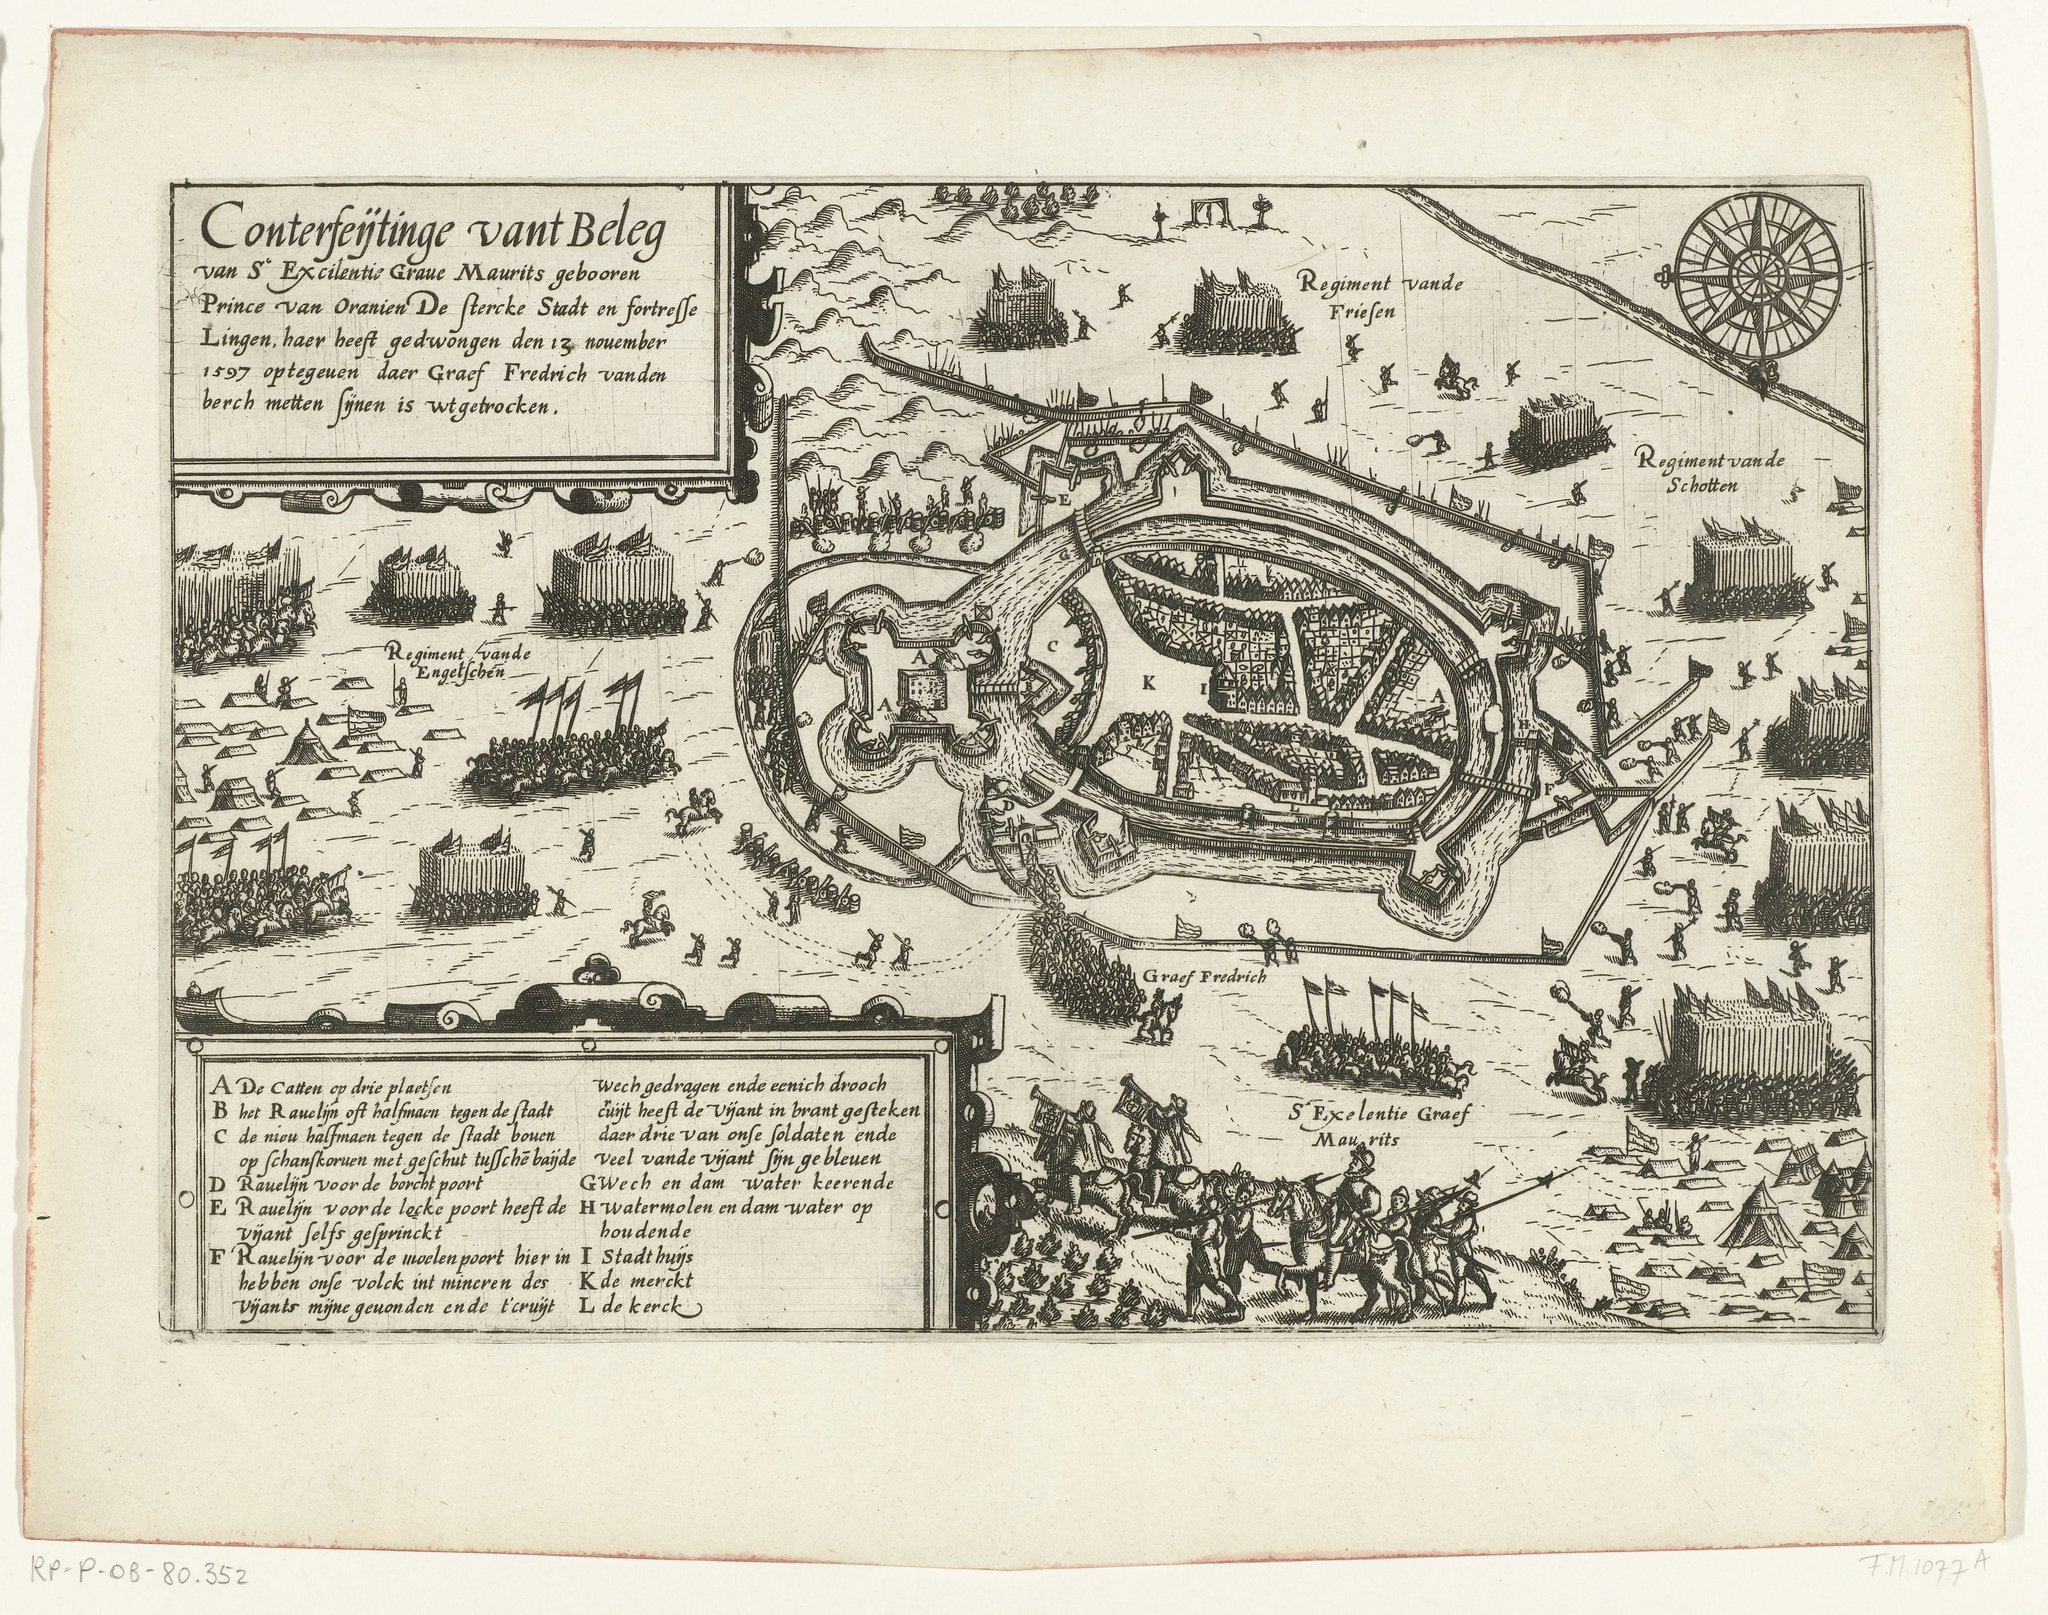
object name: print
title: Beleg en verovering van Lingen, 1597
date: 1597-1599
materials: paper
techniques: etching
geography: northern netherlands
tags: the hague, maurice (prince of orange), siege, position war, capture of city (after the siege)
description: Volgens Muller heeft deze prent gediend als voorbeeld voor de plaat van Dolendo in: J.J. Orlers, Den Nassauschen Lauren-Crans: Beschrijvinghe ende af-beeldinge van alle de victorien ... die Godt Almachtich de ... Staten der Vereenichde Nederlanden verleent heeft, deur het wijs ende clouck beleyt des Hooch-ghebooren Fursts Maurits van Nassau, J.J. Orlers en H. van Haestens, Leiden 1610, fol. 124/125.